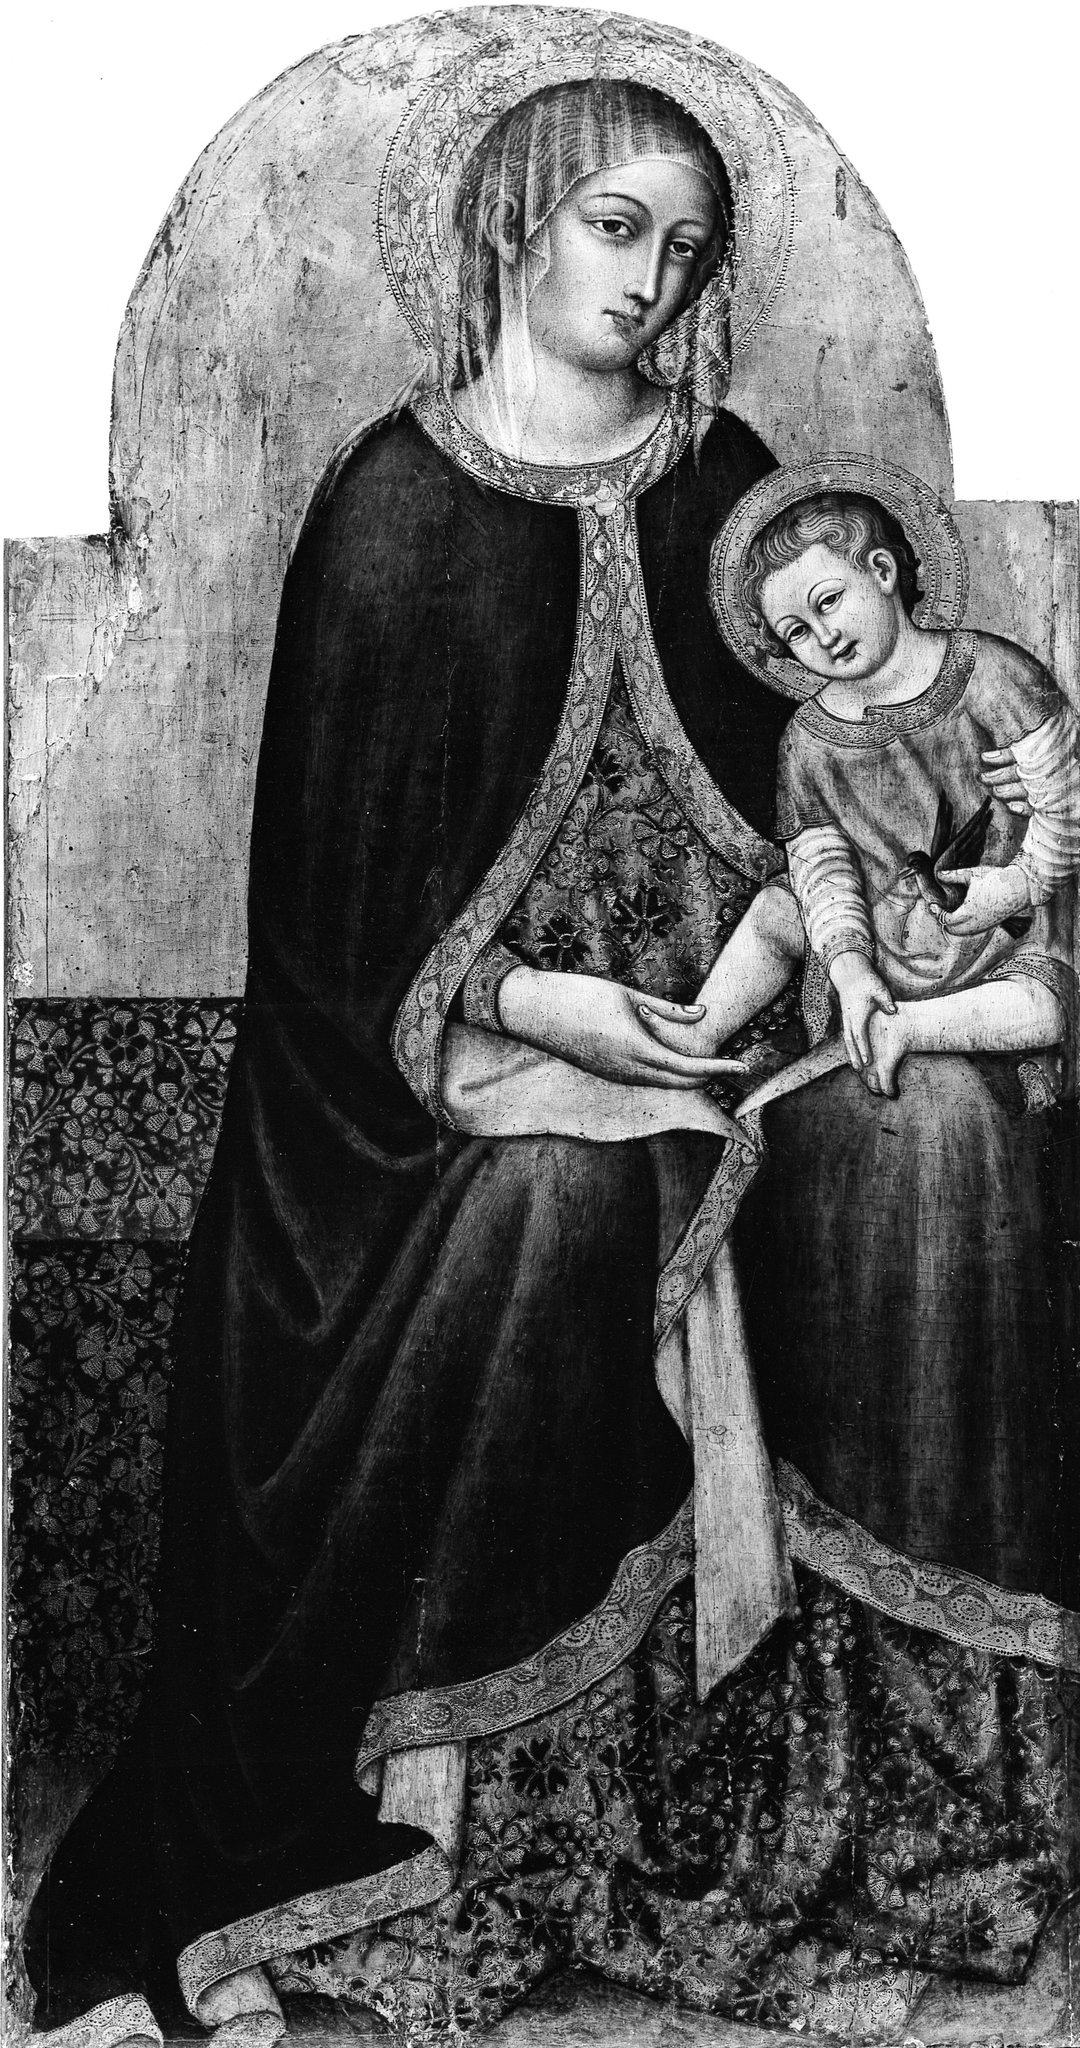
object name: painting, triptych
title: Madonna and Child with Saints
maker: priamo della quercia (priamo del pietro)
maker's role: artist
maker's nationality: italian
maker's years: 1442-1467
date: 1442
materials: gold leaf, paint, wood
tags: madonna and child,saints